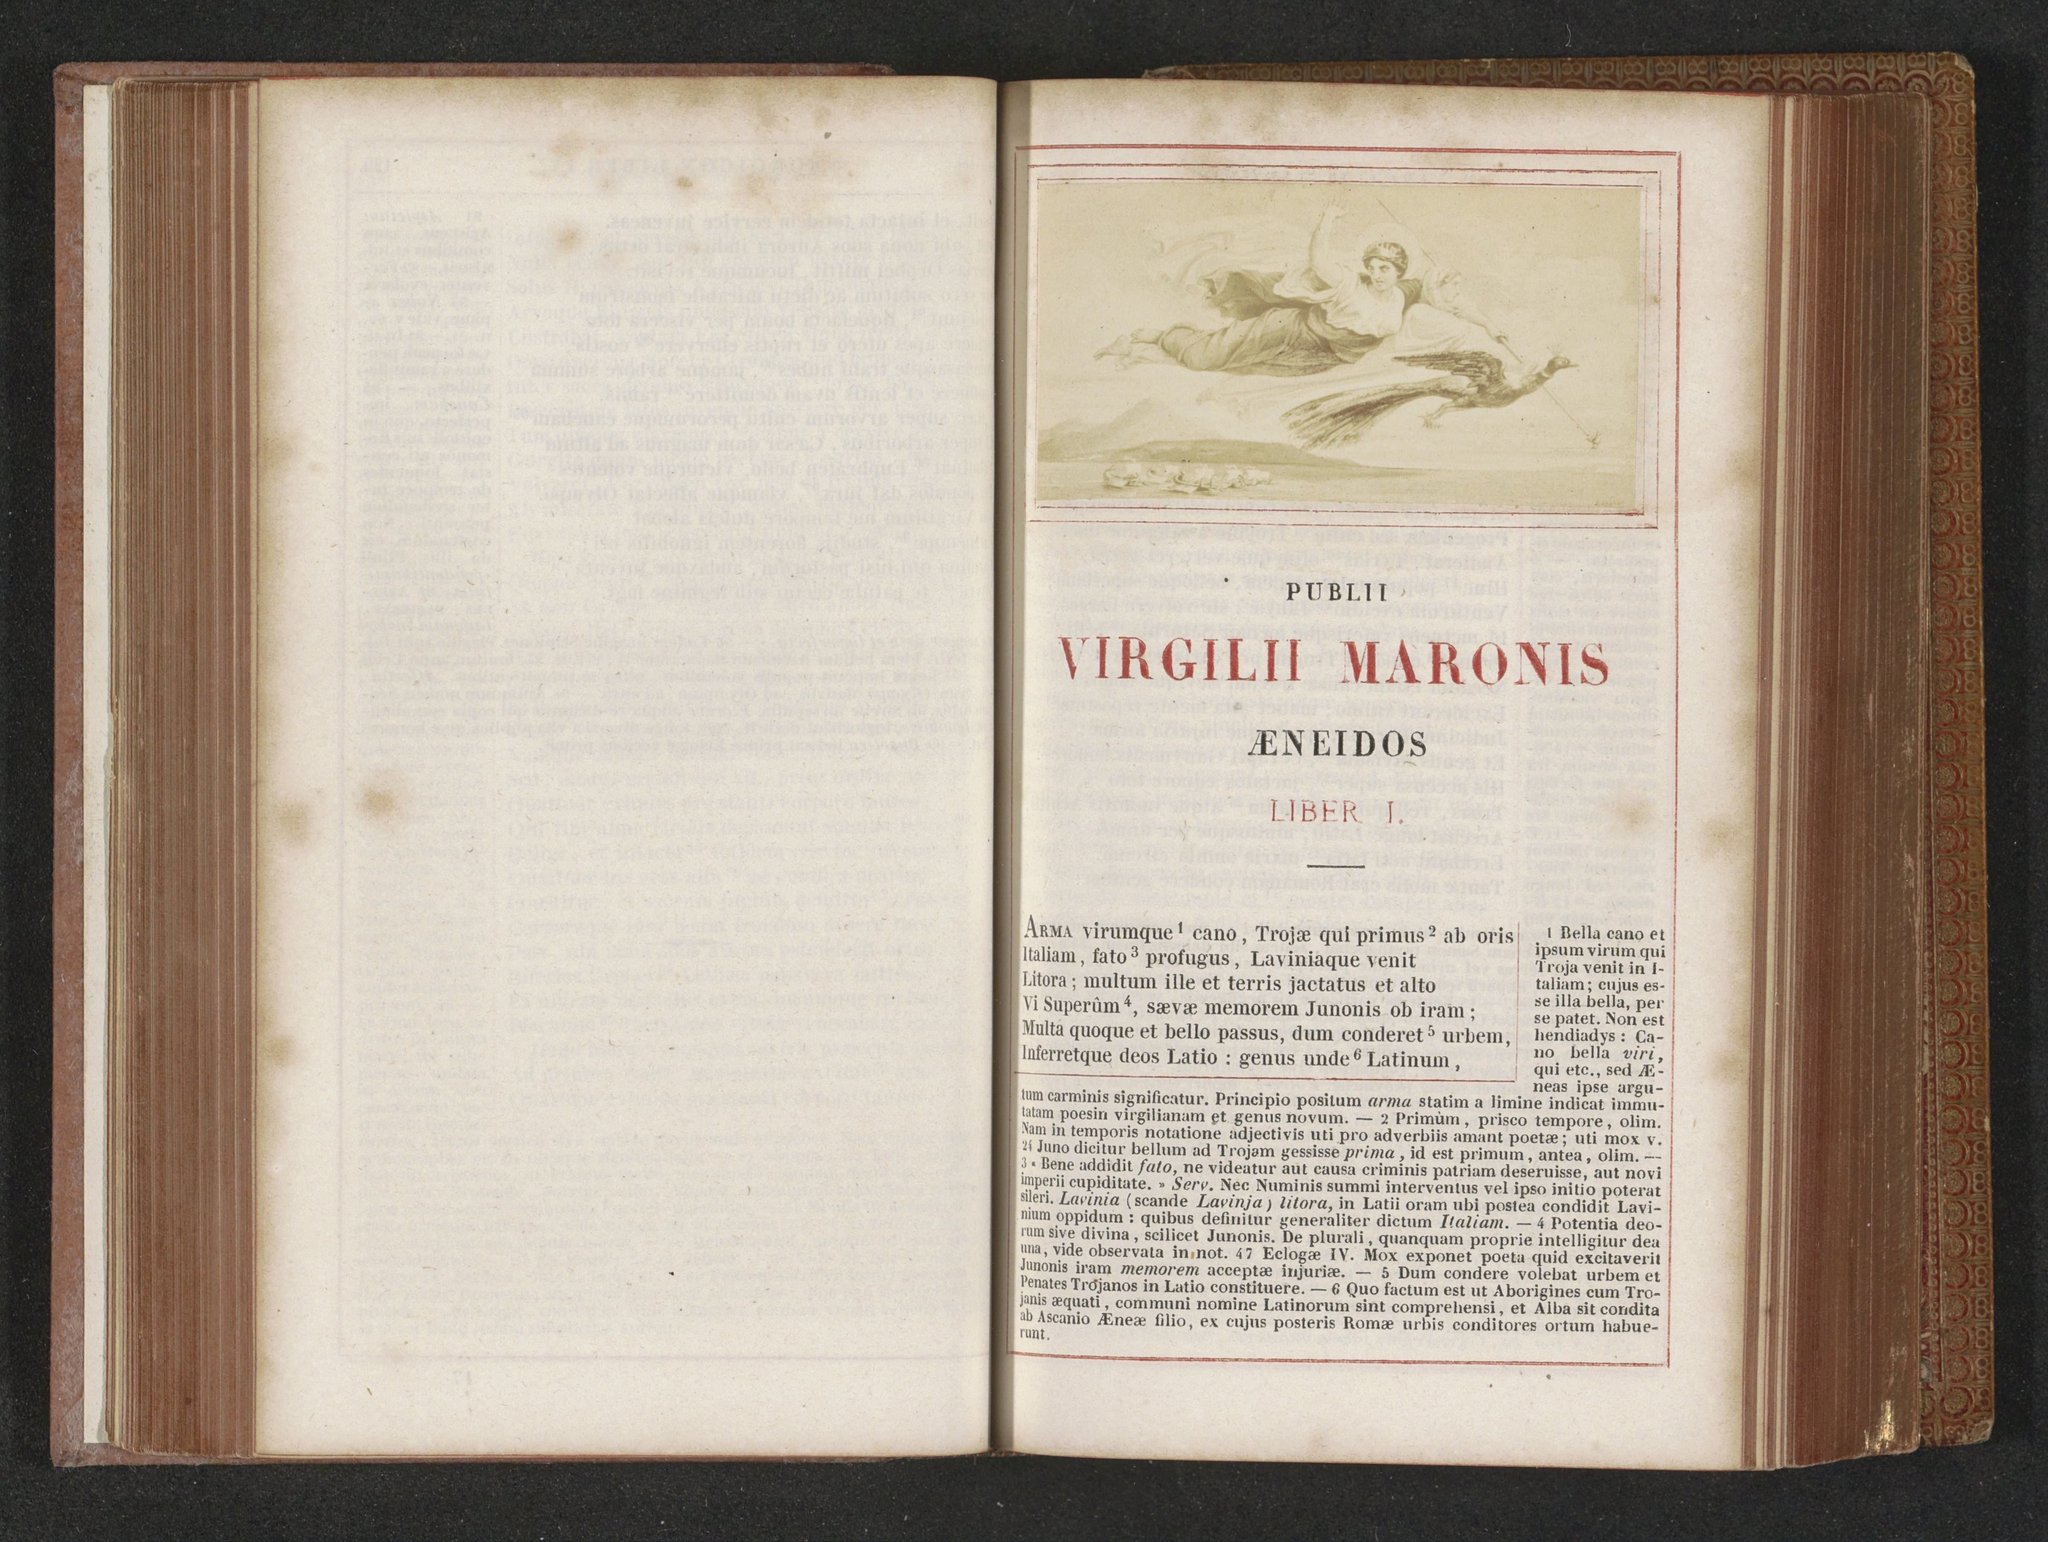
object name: reproduction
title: Fotoreproductie van een schilderij, voorstellende Juno en een pauw vliegen over schepen heen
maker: Anonymous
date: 1850-1858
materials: photographic support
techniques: albumen print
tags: (story of) juno (hera), attributes of juno (with name)